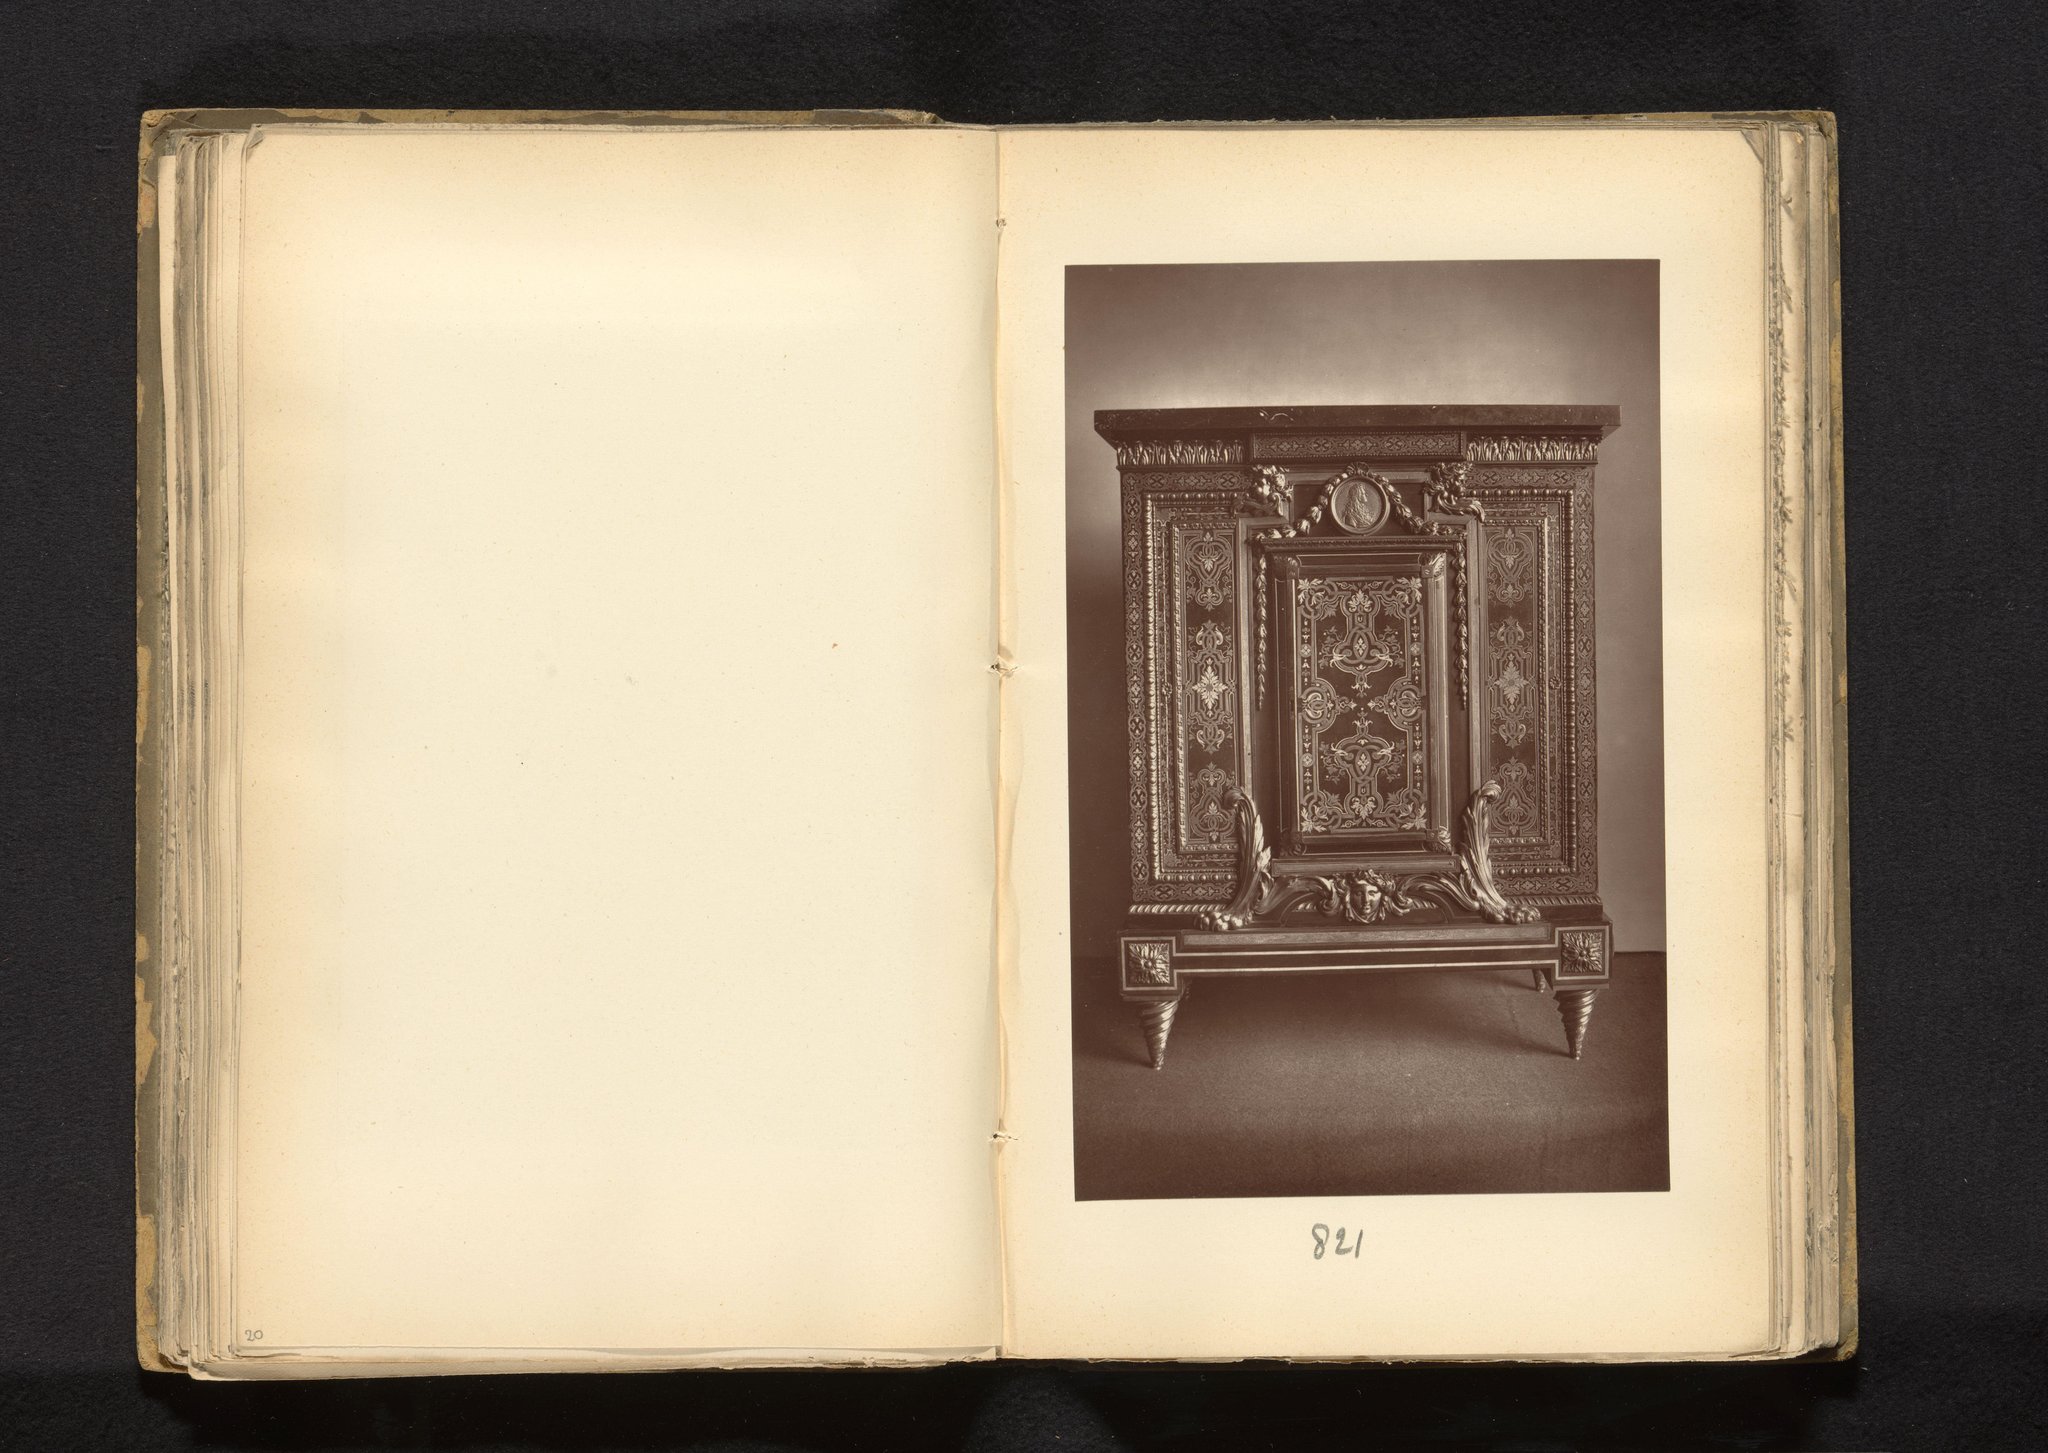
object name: photomechanical print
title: Gedecoreerd kabinet in de stijl van Lodewijk XIV, uit de collectie van Christopher Beckett Denison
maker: Anonymous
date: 1880-1885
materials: paper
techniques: woodburytype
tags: ornamental cupboard (+ wood and other phytogenic material)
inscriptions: number: ‘821’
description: Prent op derde ongenummerde pagina na pagina 82.